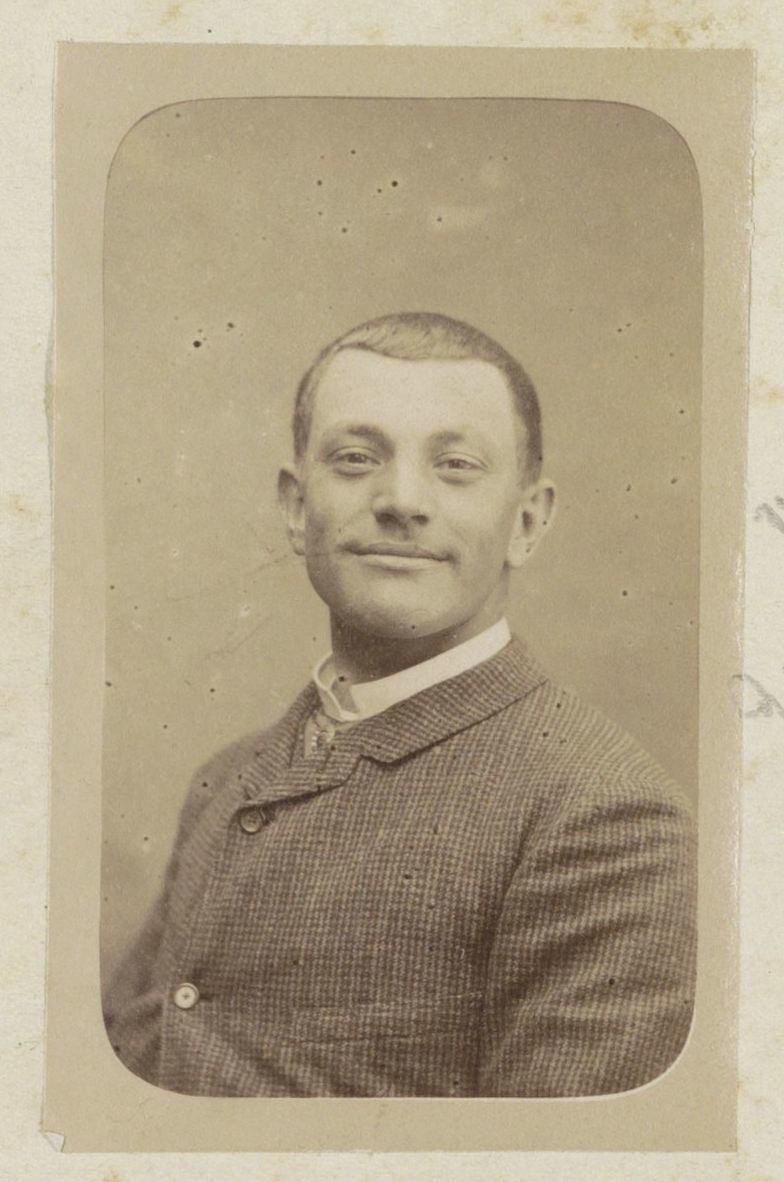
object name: photograph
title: Portret van een glimlachende Fransman, aangeduid als Emile, van voren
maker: Anonymous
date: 1883-1886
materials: photographic support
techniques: albumen print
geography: france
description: Onderdeel van Album van een Franse amateurfotograaf met opnames van familie, militairen, industrie, landschappen en bezienswaardigheden in Frankrijk.